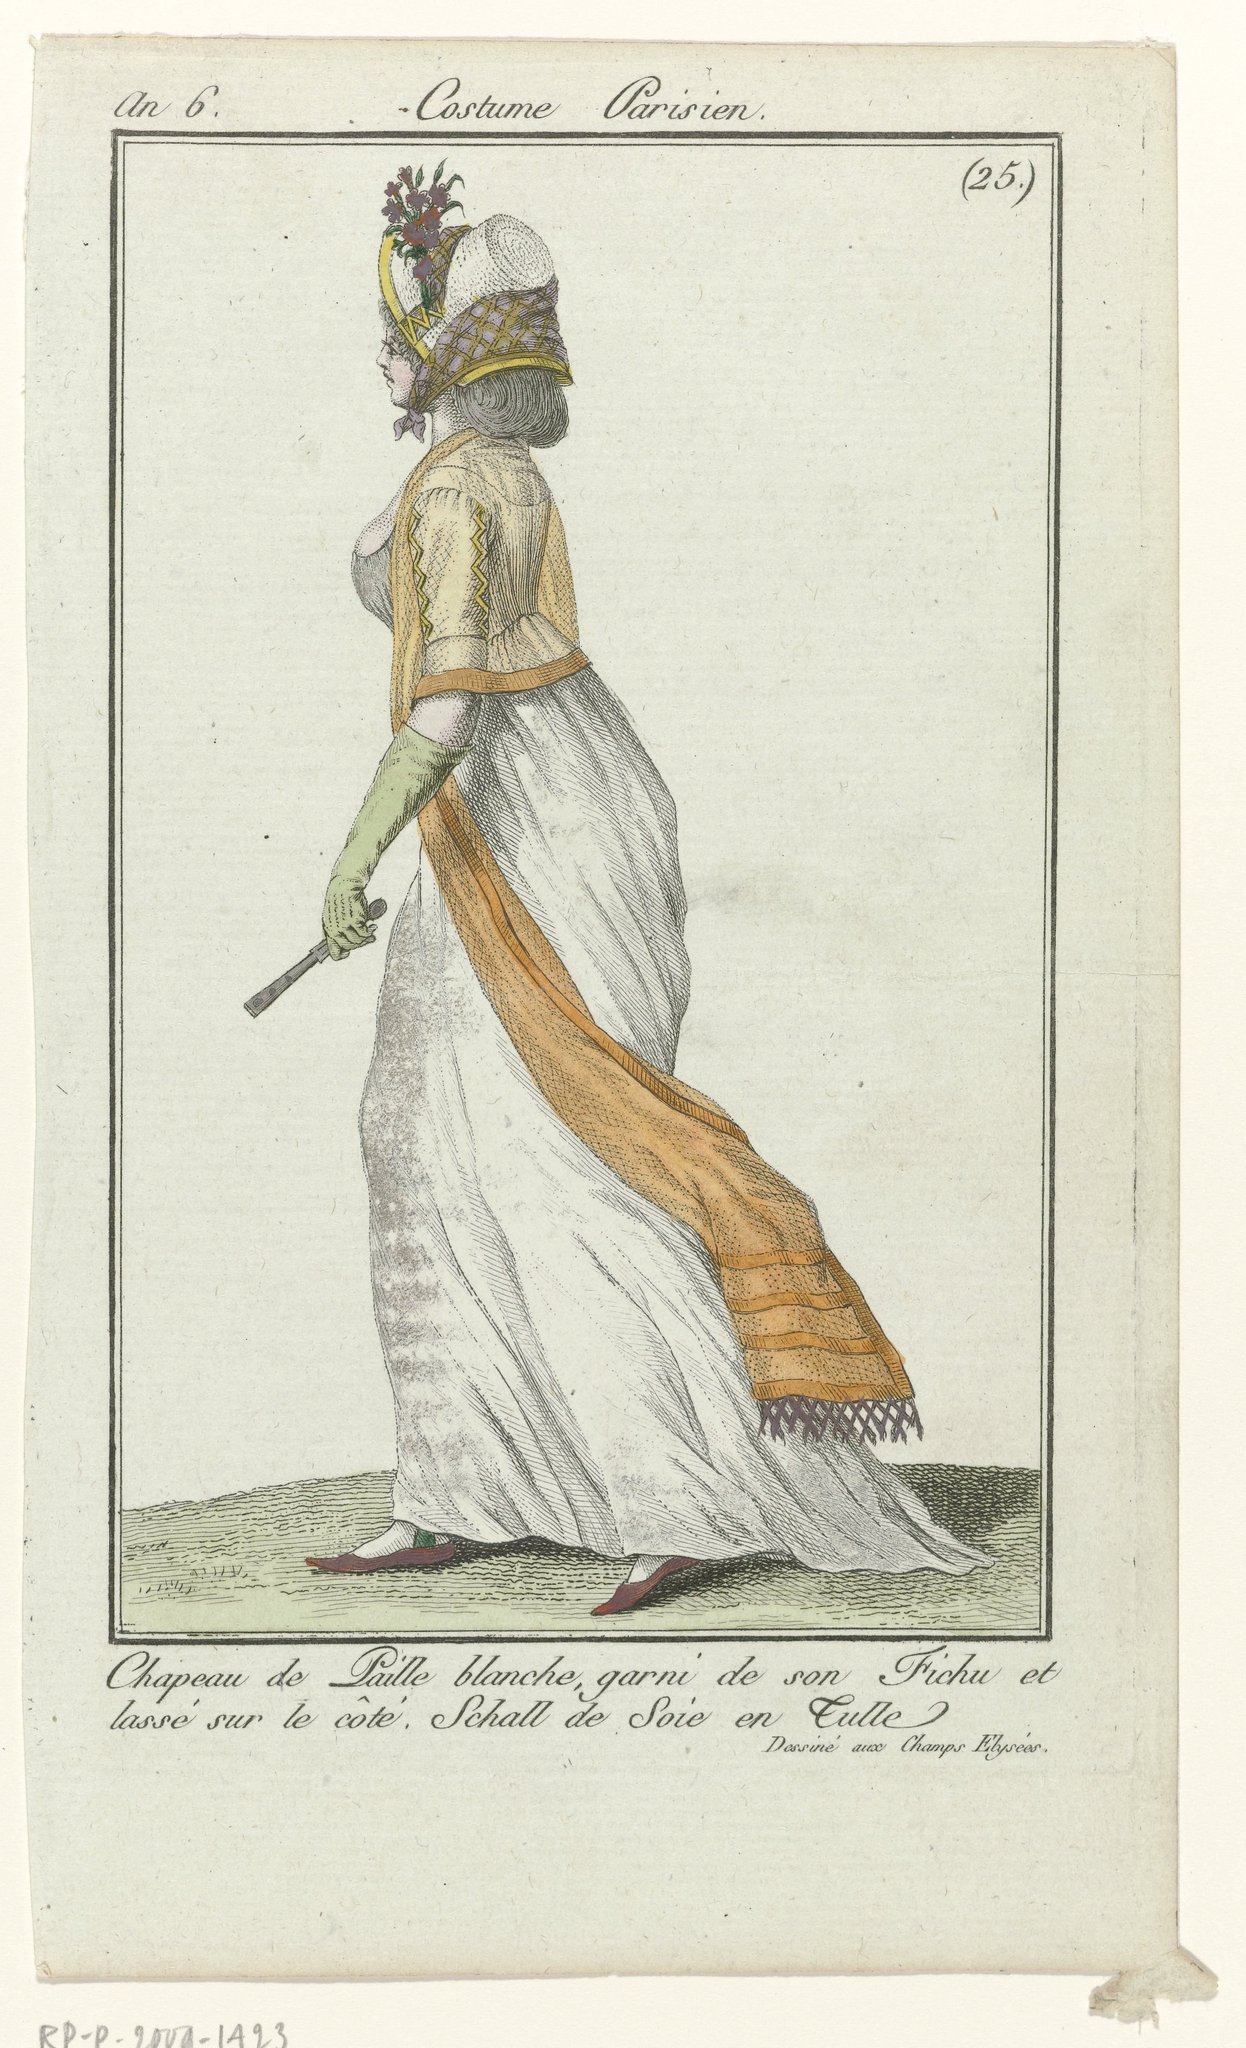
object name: fashion print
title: Journal des Dames et des Modes, Costume Parisien, 8 juin 1798, An 6 (42) : Chapeau de Paill (...)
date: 1798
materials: paper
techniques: engraving, hand coloring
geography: paris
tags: clothing for the upper part of the body (shawl) (+ women's clothes), head-gear (+ women's clothes), fashion plates, shoes, sandals (+ women's clothes), gloves, mittens, etc. (+ women's clothes), dress, gown (+ women's clothes), fan (+ women's clothes), piece of clothing covering the breast or décolleté (fichu) (+ women's clothes)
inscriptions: title: ‘Costume Parisien.’, caption: ‘Chapeau de Paille blanche, garnie de son Fichu et lassé sur le Côté. Schall de Soie en Tulle. / Dessiné aux Champs Elysées’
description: Witte strohoed versierd met een geruite fichu, rijgsluiting aan de zijkant en bloemen. Japon met korte mouwen en sleepje. Om de schouders een lange sjaal van zijde en tule. Verdere accessoires: lange handschoen, waaier, platte schoenen met puntige neuzen. R.o. de vermelding dat dit kostuum naar het leven is getekend op de 'Champs Élysées'. De prent maakt deel uit van het modetijdschrift Journal des Dames et des Modes, uitgegeven door Sellèque, Parijs, 1797-1839.